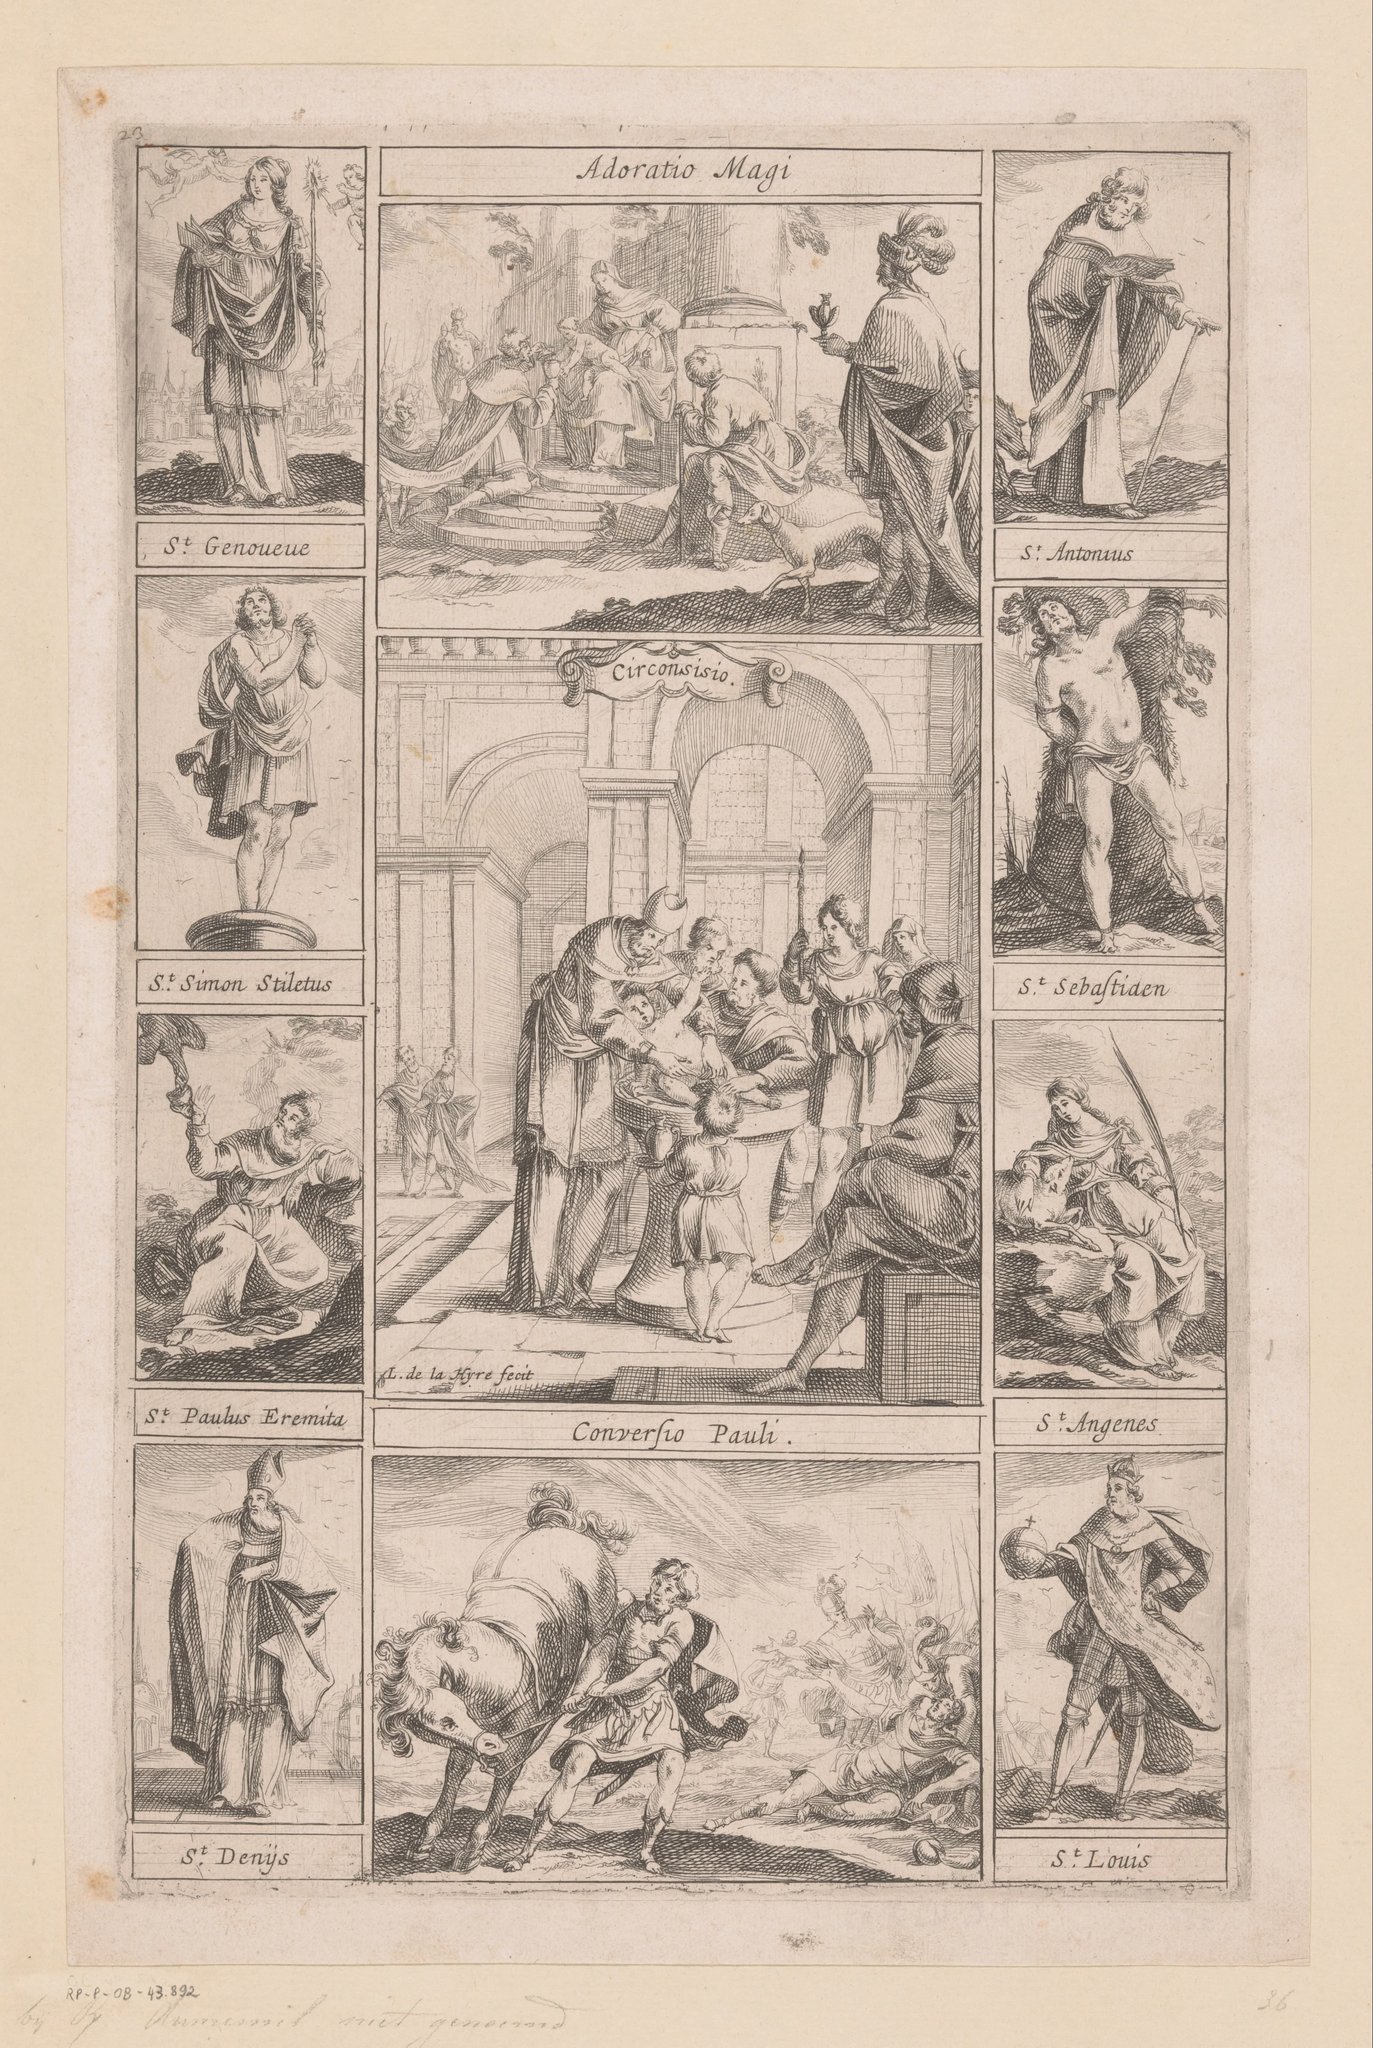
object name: print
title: Aanbidding door de Wijzen, besnijdenis en bekering van Paulus omgeven door acht heiligen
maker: laurent de la hire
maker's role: draughtsman, painter, print maker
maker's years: 1606-1656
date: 1616-1656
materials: paper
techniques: etching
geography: france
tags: adoration of the kings: the wise men present their gifts to the christ-child (gold, frankincense and myrrh), saints, story of the conversion of paul (acts 9:1-18), circumcision of the christ-child by the priest in the temple (luke 2:21)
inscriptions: number: ‘23’, collector's mark: Lugt 240